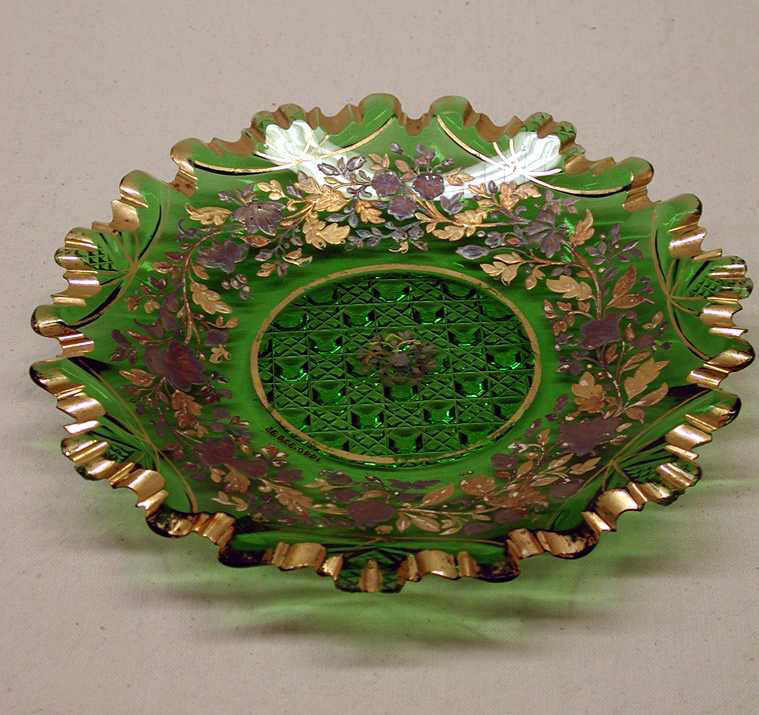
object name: dish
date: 1870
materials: enamel, gilt, glass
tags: flowers